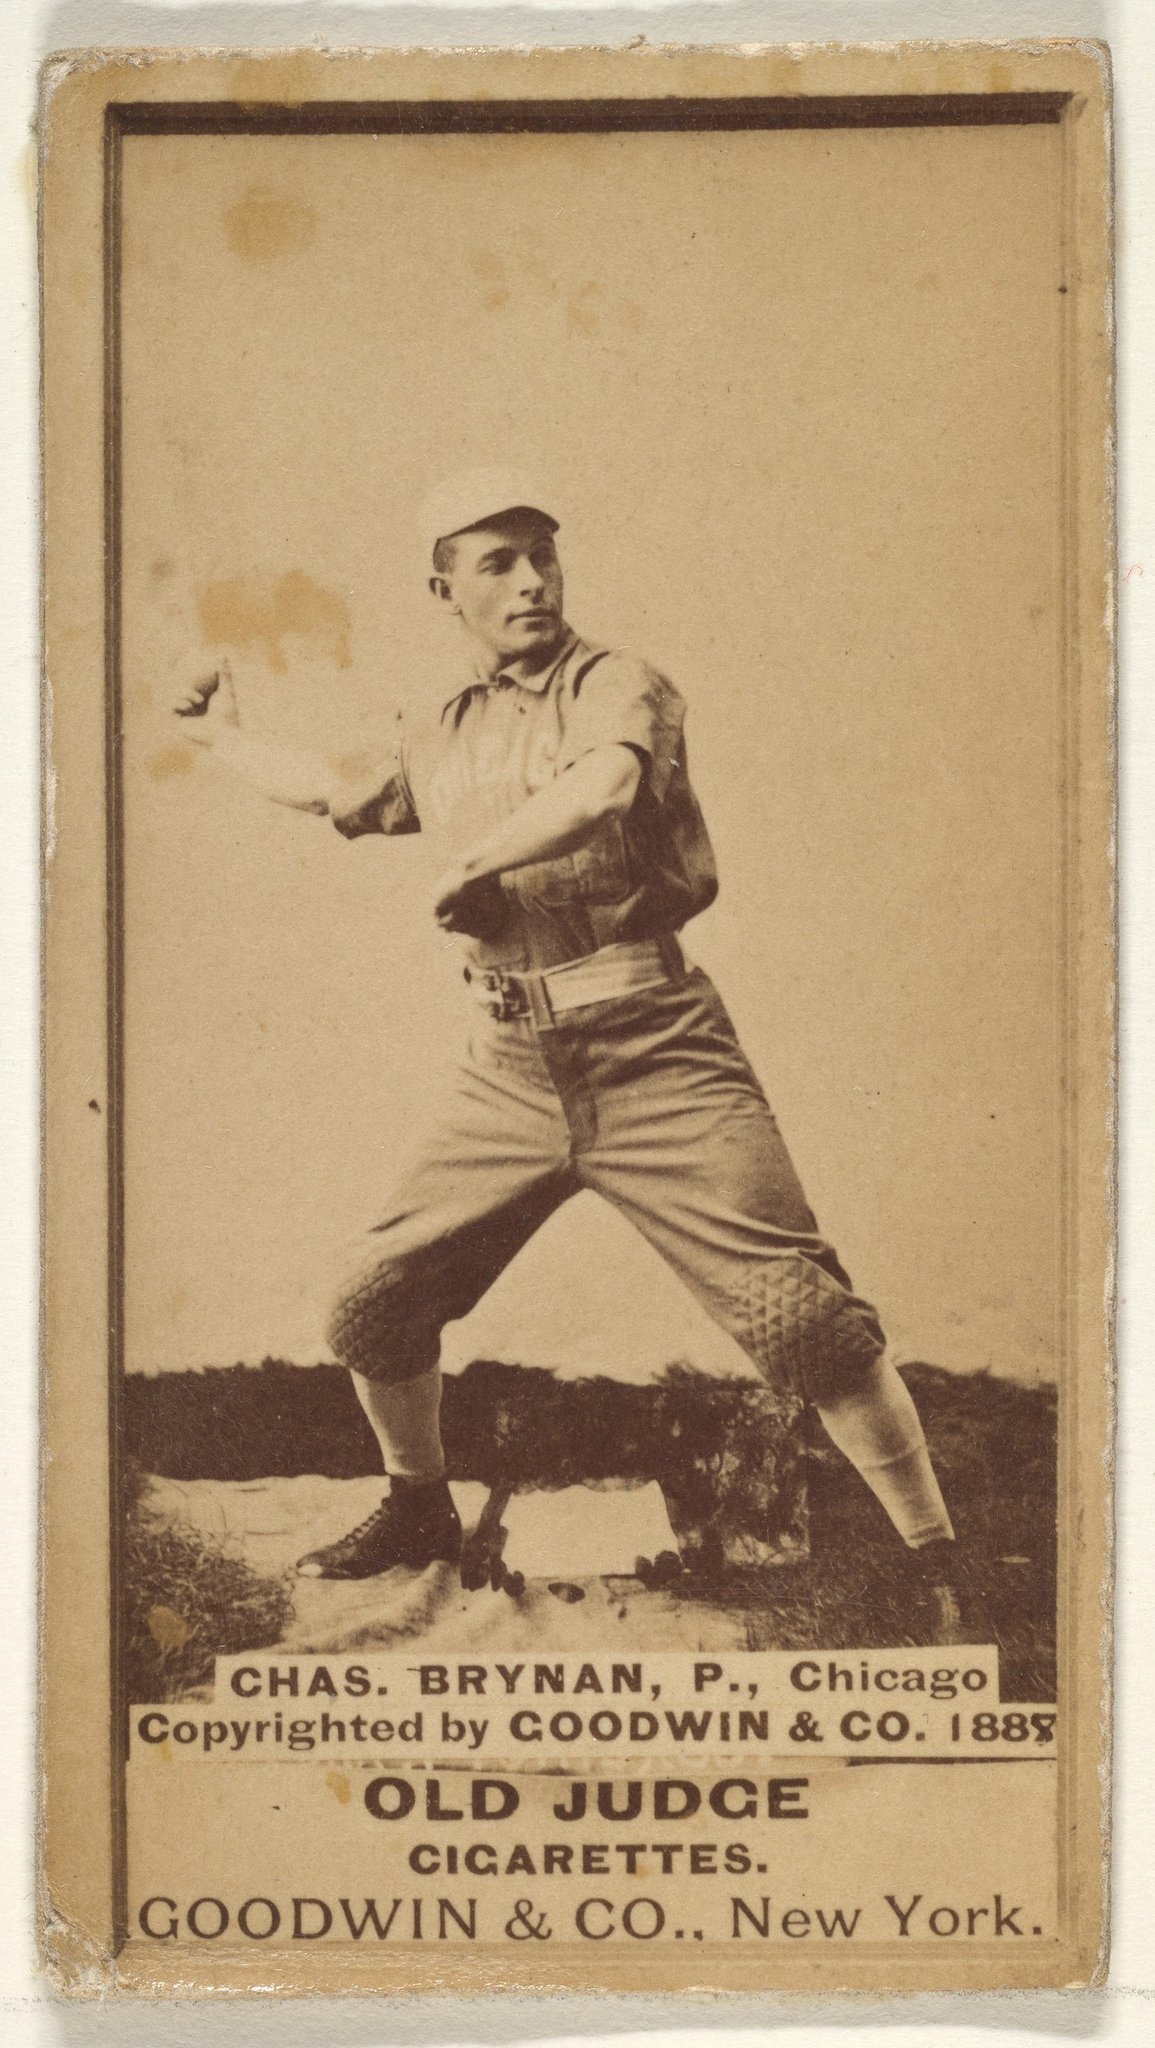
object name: baseball card, photograph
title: Chas. Brynan, Pitcher, Chicago, from the Old Judge series (N172) for Old Judge Cigarettes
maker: goodwin & company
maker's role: publisher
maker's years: 1850-1950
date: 1888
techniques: albumen silver print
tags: men,portraits,baseball,athletes